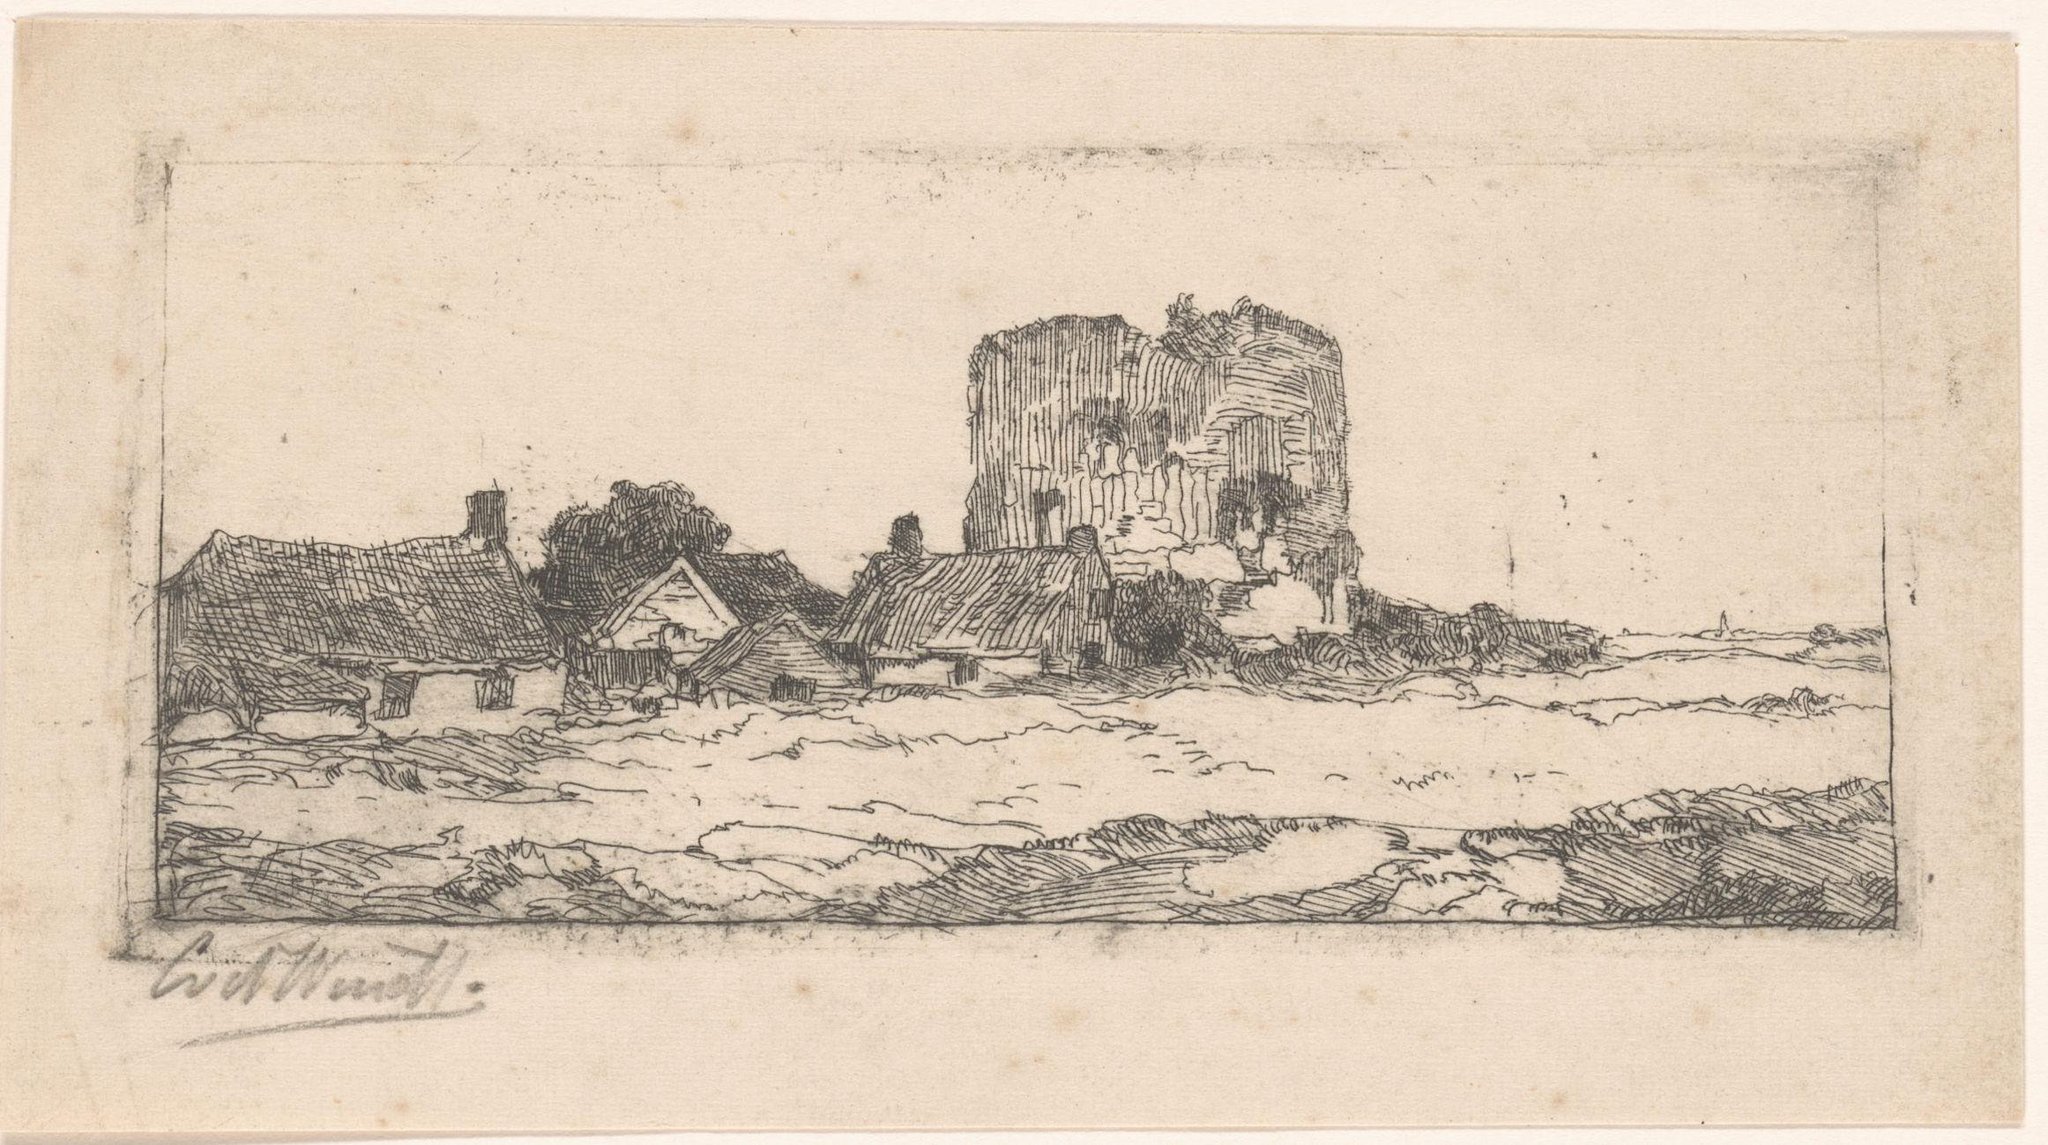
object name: print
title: Ruïne van Teylingen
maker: chris van der windt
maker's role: print maker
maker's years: 1877-1952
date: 1887-1952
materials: paper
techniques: etching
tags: landscape with ruins, ruin of a dwelling, house, castle, etc.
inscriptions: collector's mark: Lugt 2228